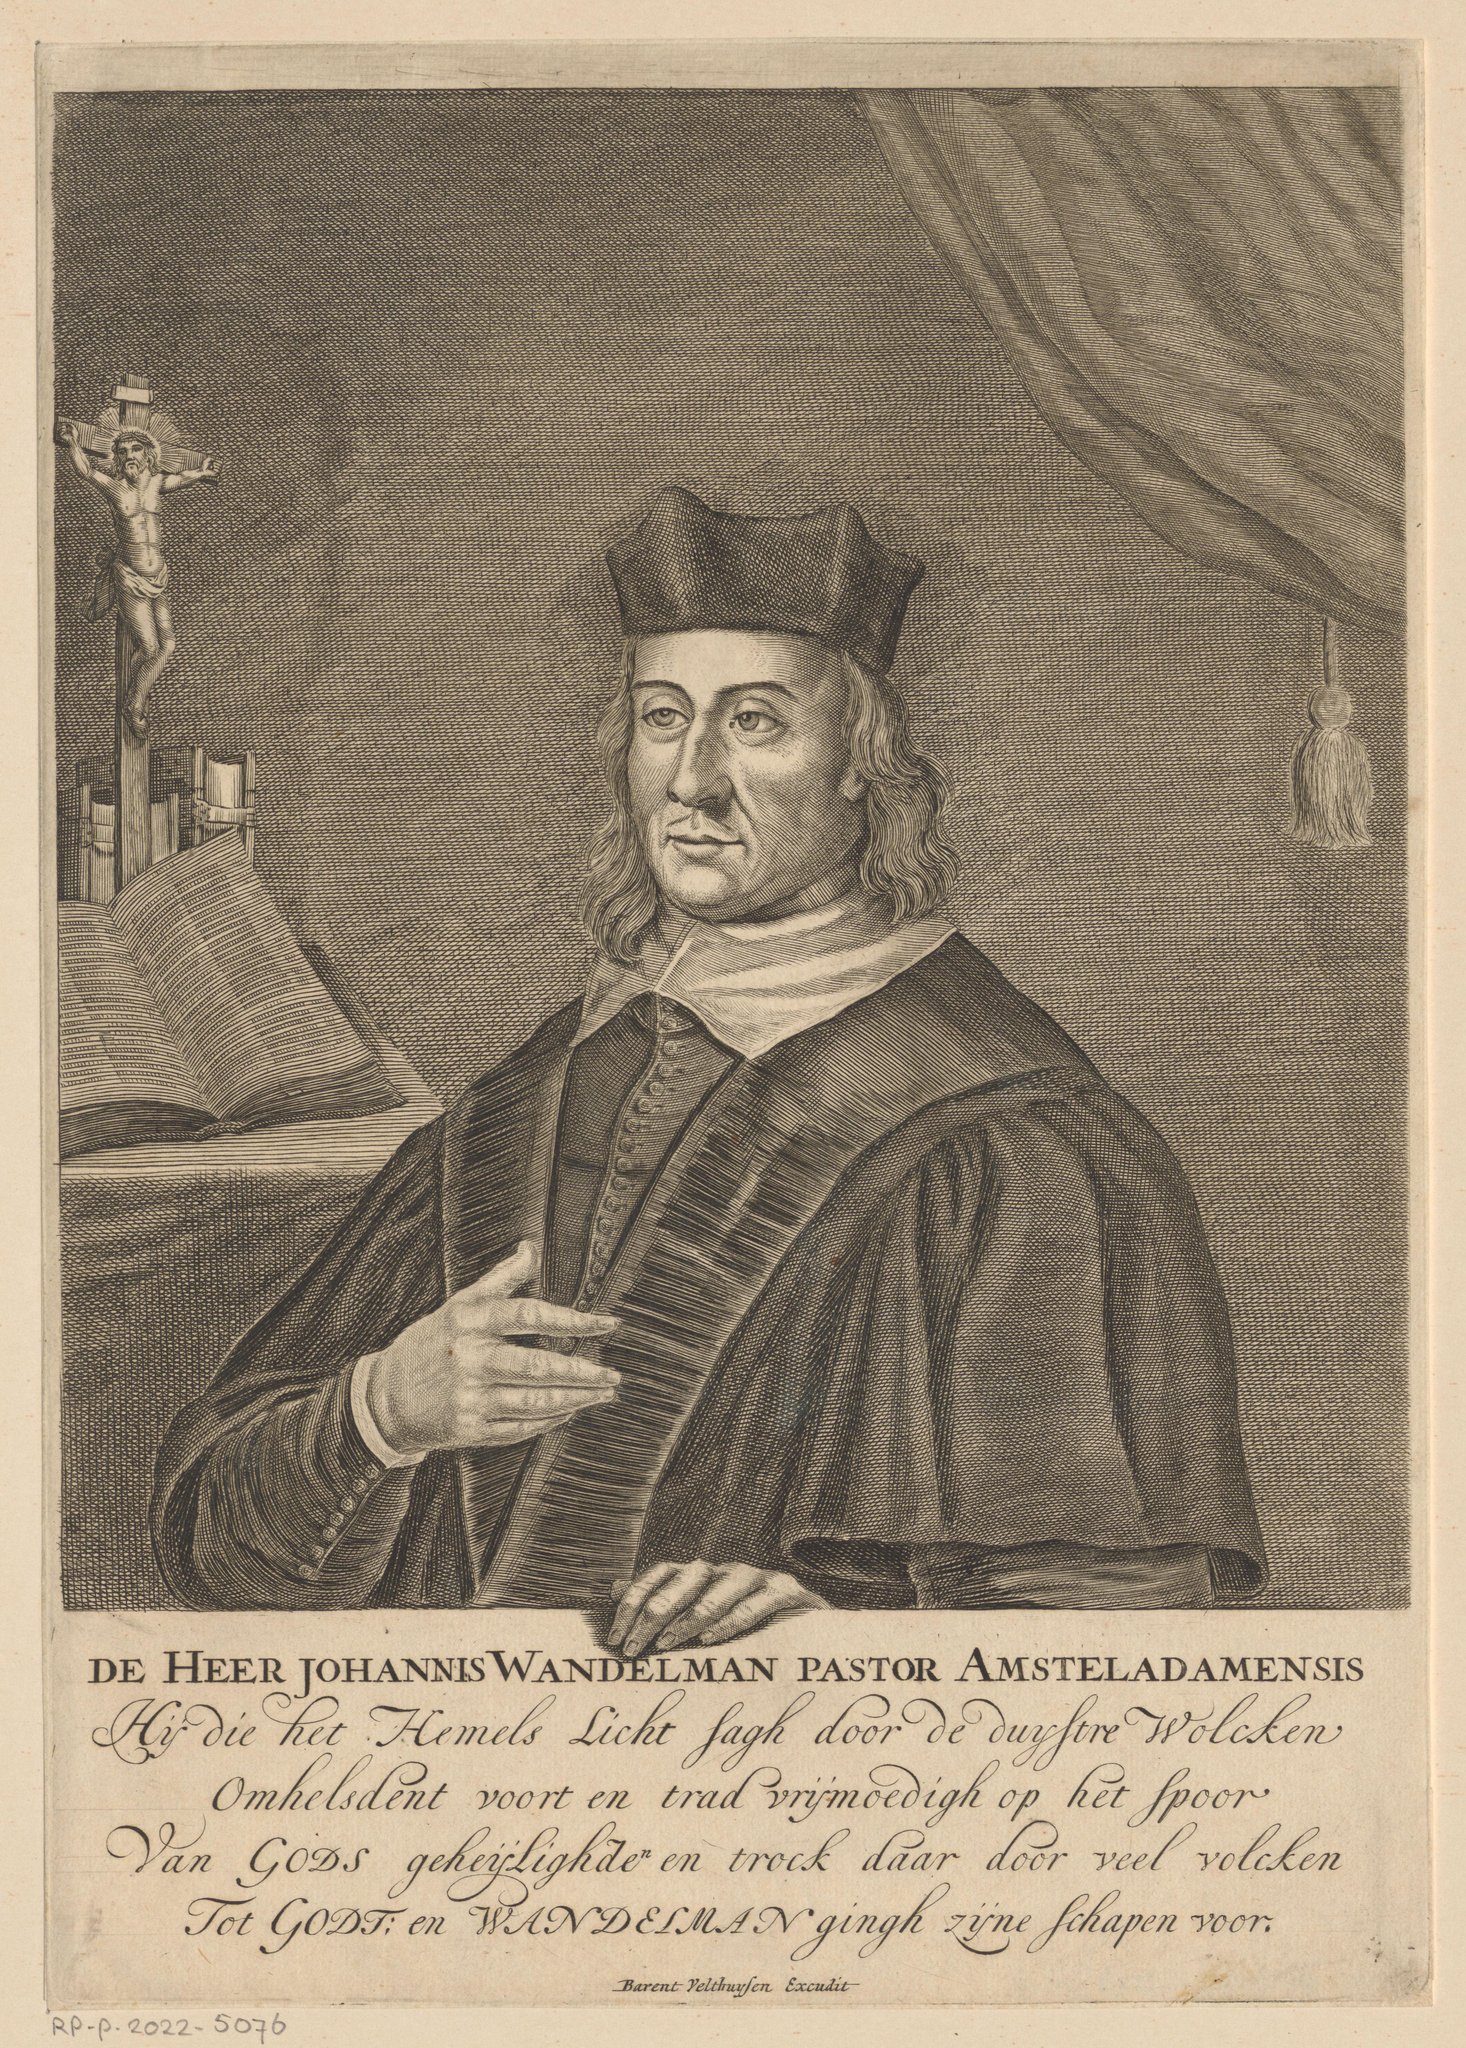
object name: print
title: Portret van Joannes Wandelman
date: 1700-1750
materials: paper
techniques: engraving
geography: amsterdam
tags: amsterdam, priest (roman catholic), historical persons, crucifix ~ personal devotion, the bible as a book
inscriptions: collector's mark: Lugt 2228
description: Onder het portret een vierregelig vers in het Nederlands.